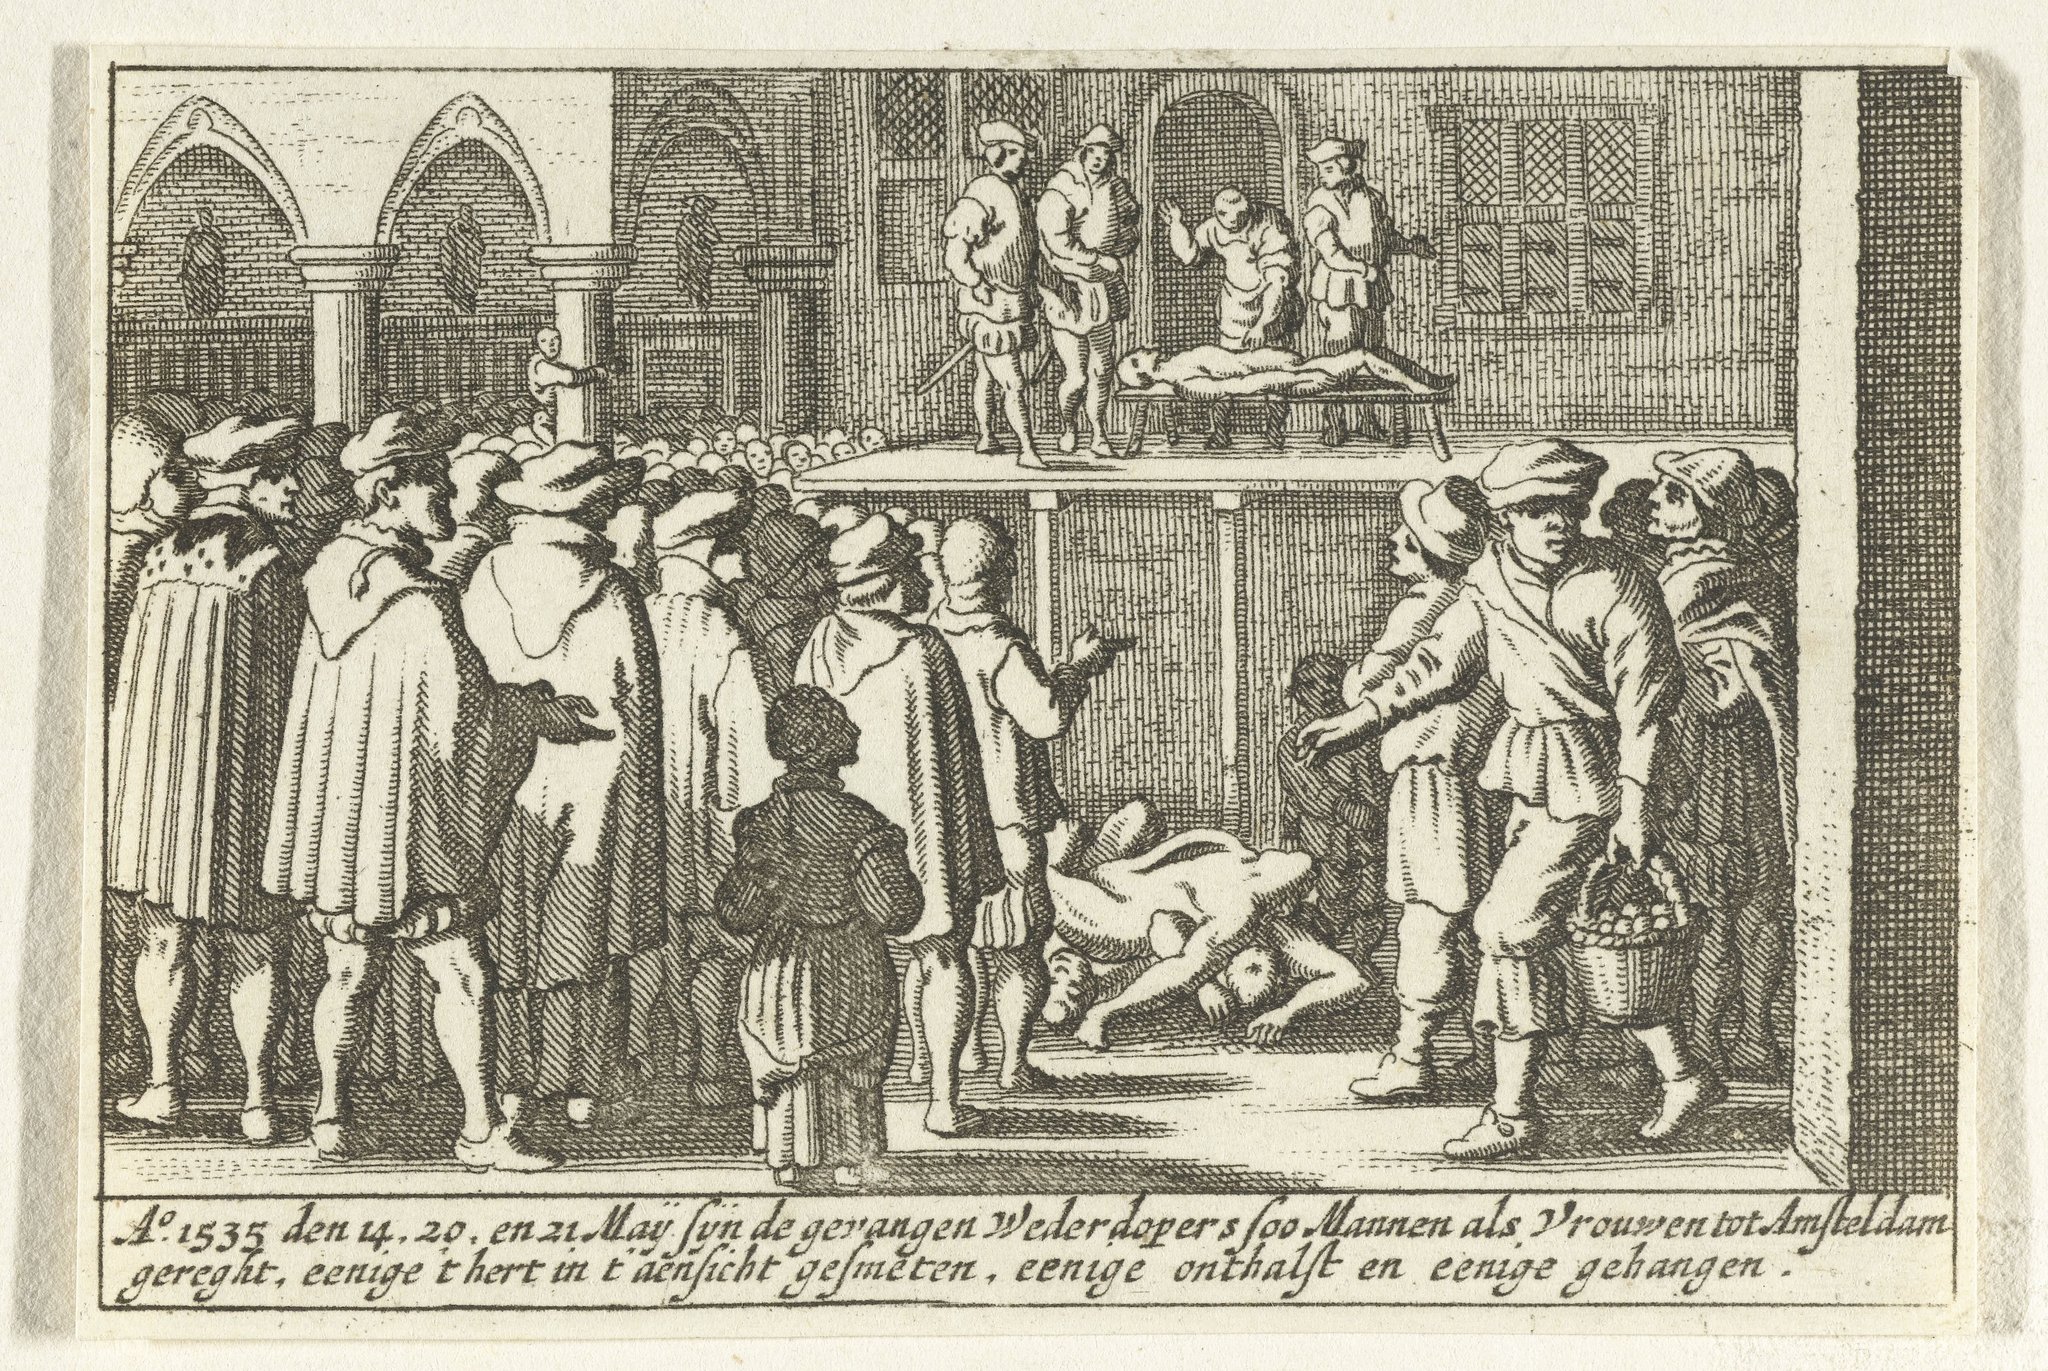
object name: print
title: Terechtstelling van de wederdopers op het schavot op de Dam, 1535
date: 1629-1652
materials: paper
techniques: etching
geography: northern netherlands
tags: on the scaffold or place of execution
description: Deze prenten zijn gebaseerd op de oorspronkelijke anonieme gravures in de eerste uitgave L. Hortensius, Van den oproer der weder-dooperen, 1614. Alle 8 prenten op op één blad geplakt. Naar het verloren gegane schilderij van Barend Dircksz. in het oude stadhuis te Amsterdam.